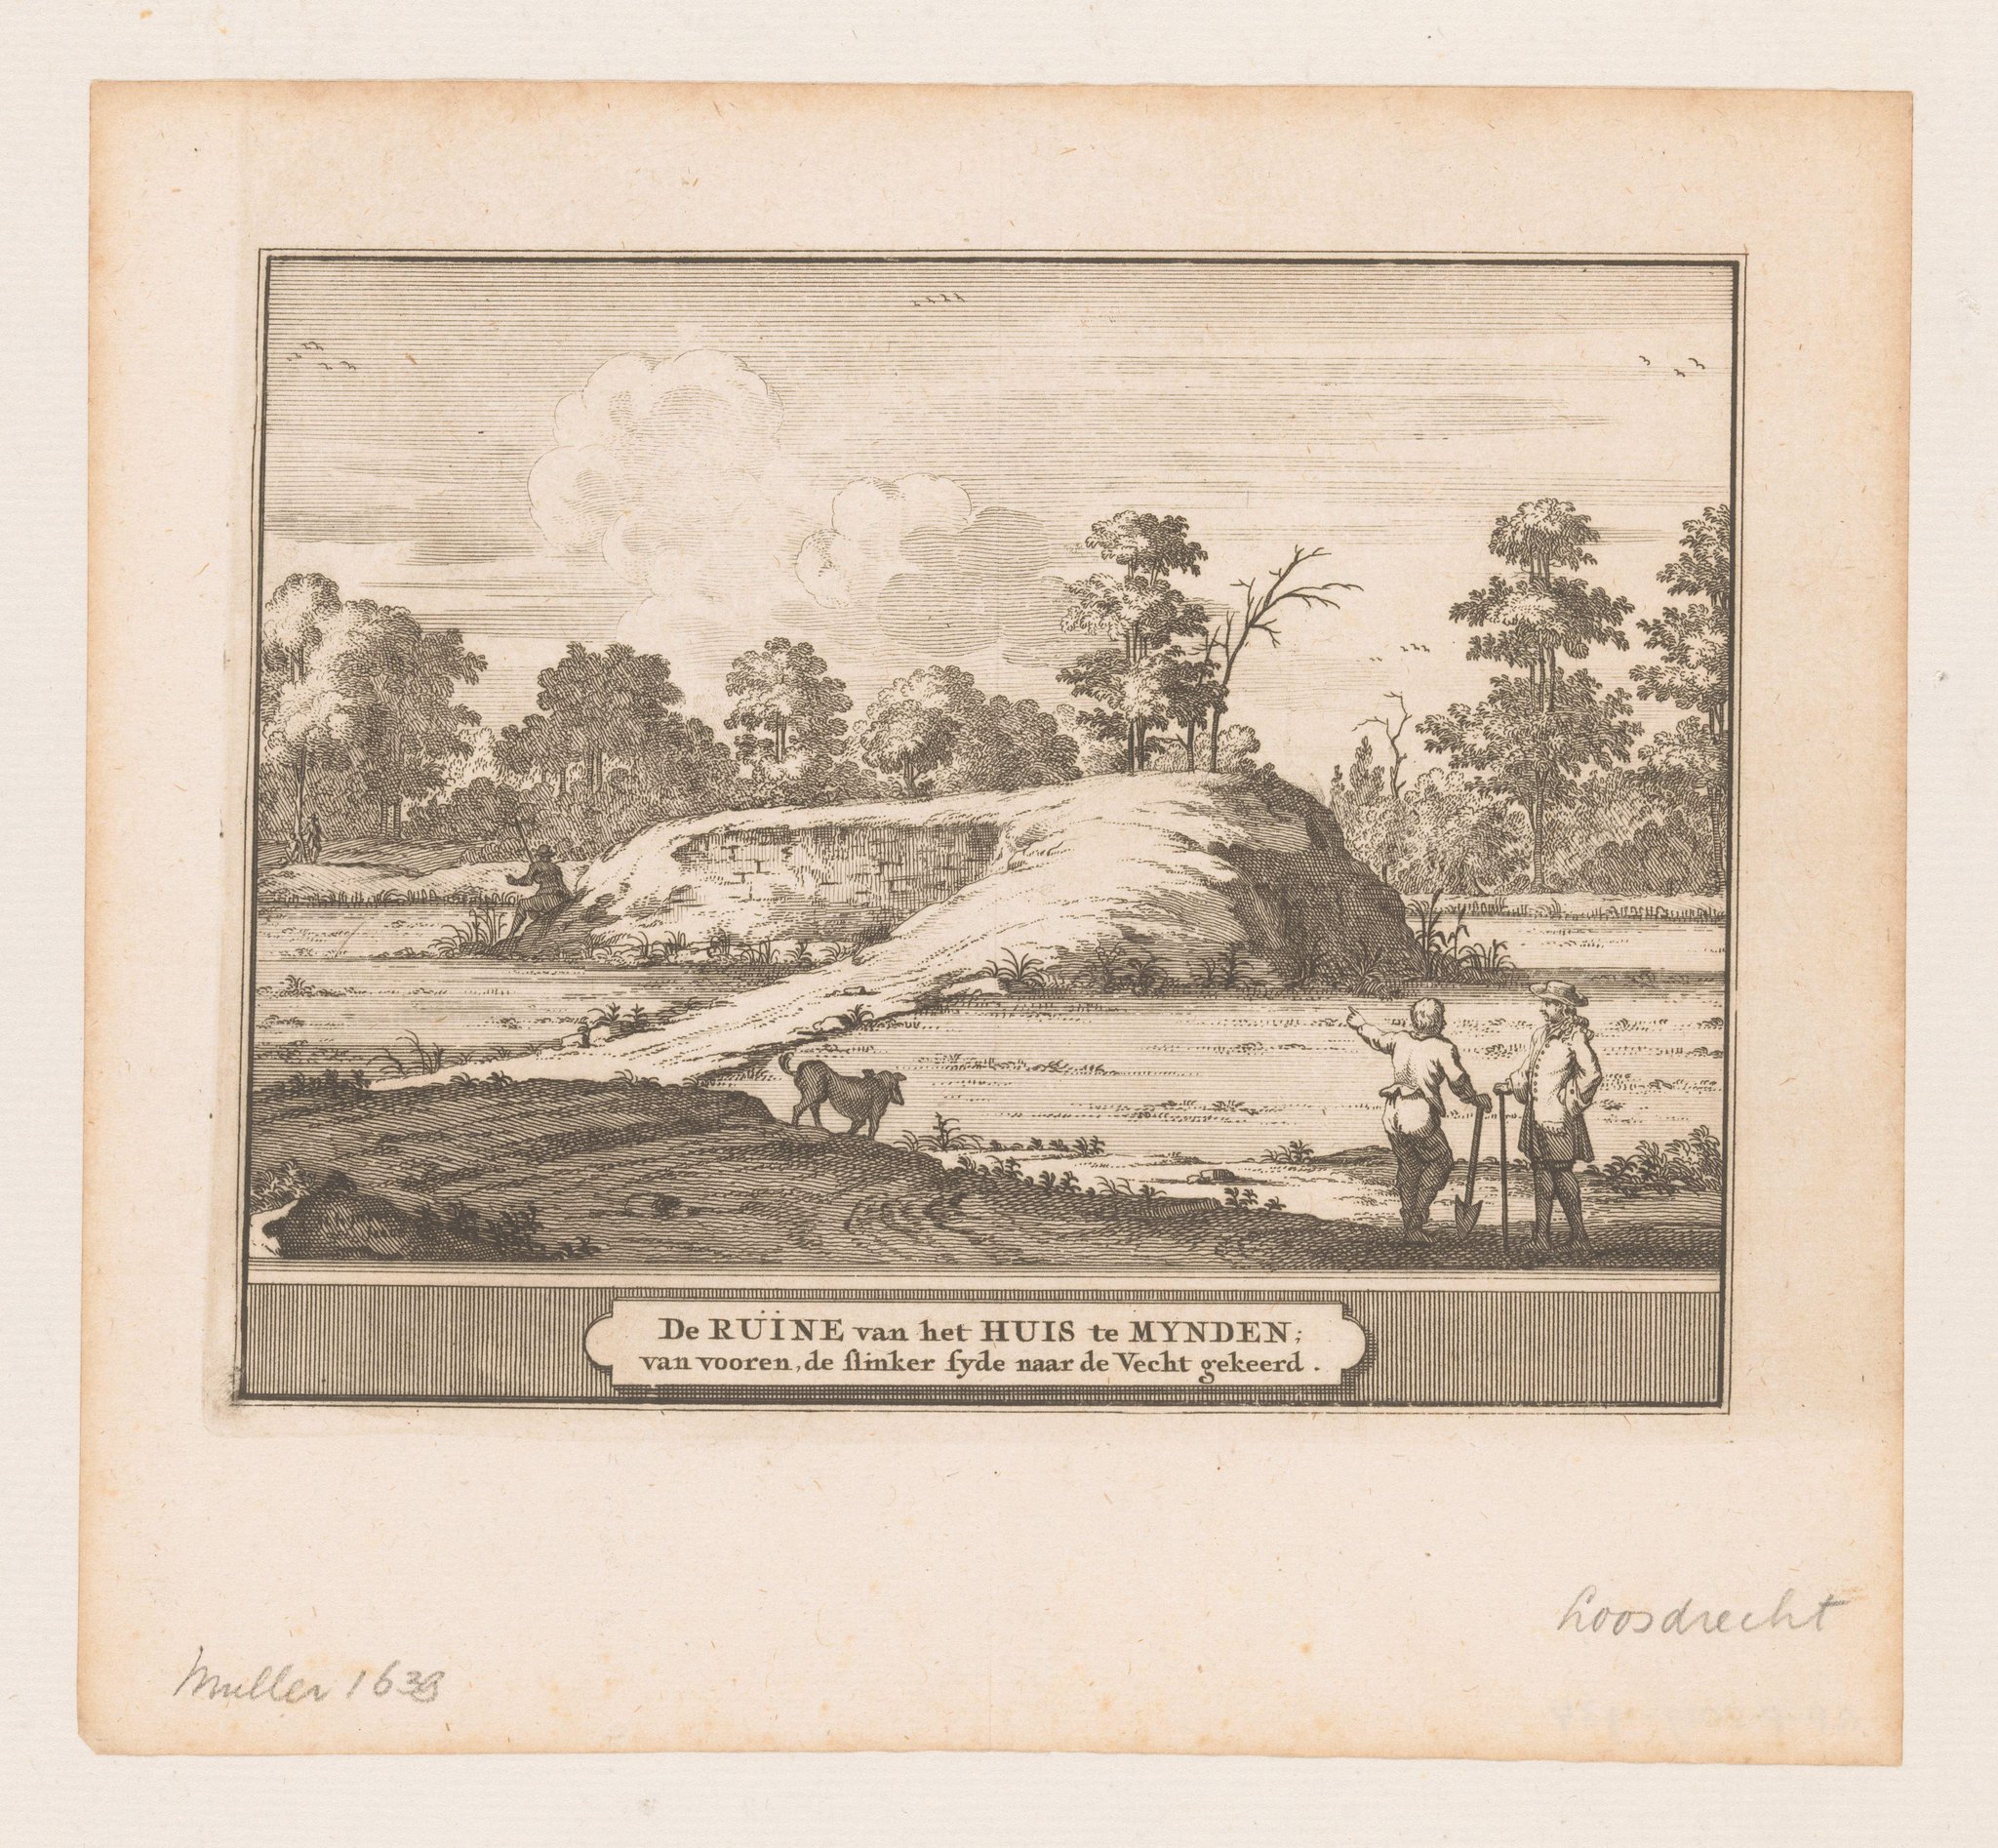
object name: print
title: De Ruïne van het huis te Mynden; van vooren, de slinker syde naar de Vecht gekeerd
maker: jacobus schijnvoet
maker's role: draughtsman, print maker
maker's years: 1685-1743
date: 1711-1774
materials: paper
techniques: etching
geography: amsterdam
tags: landscape with ruins, vecht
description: Prent opgenomen in: Smids, Ludolph. Schatkamer der Nederlandsse[!] oudheden; of Woordenboek, behelsende Nederlands steden, Amsterdam: Pieter de Coup, 1711. Verscheen tevens in de heruitgave van voorgenoemd werk in 1737 en 1774. In 1721 verscheen er een uitgave met alleen de prenten: Nederlandsche oudheden, bestaande in zestig verbeeldingen (...) gelegen in Holland, 't Sticht van Utrecht en Gelderland enz. Amsterdam: Hendrik Bosch, 1721.